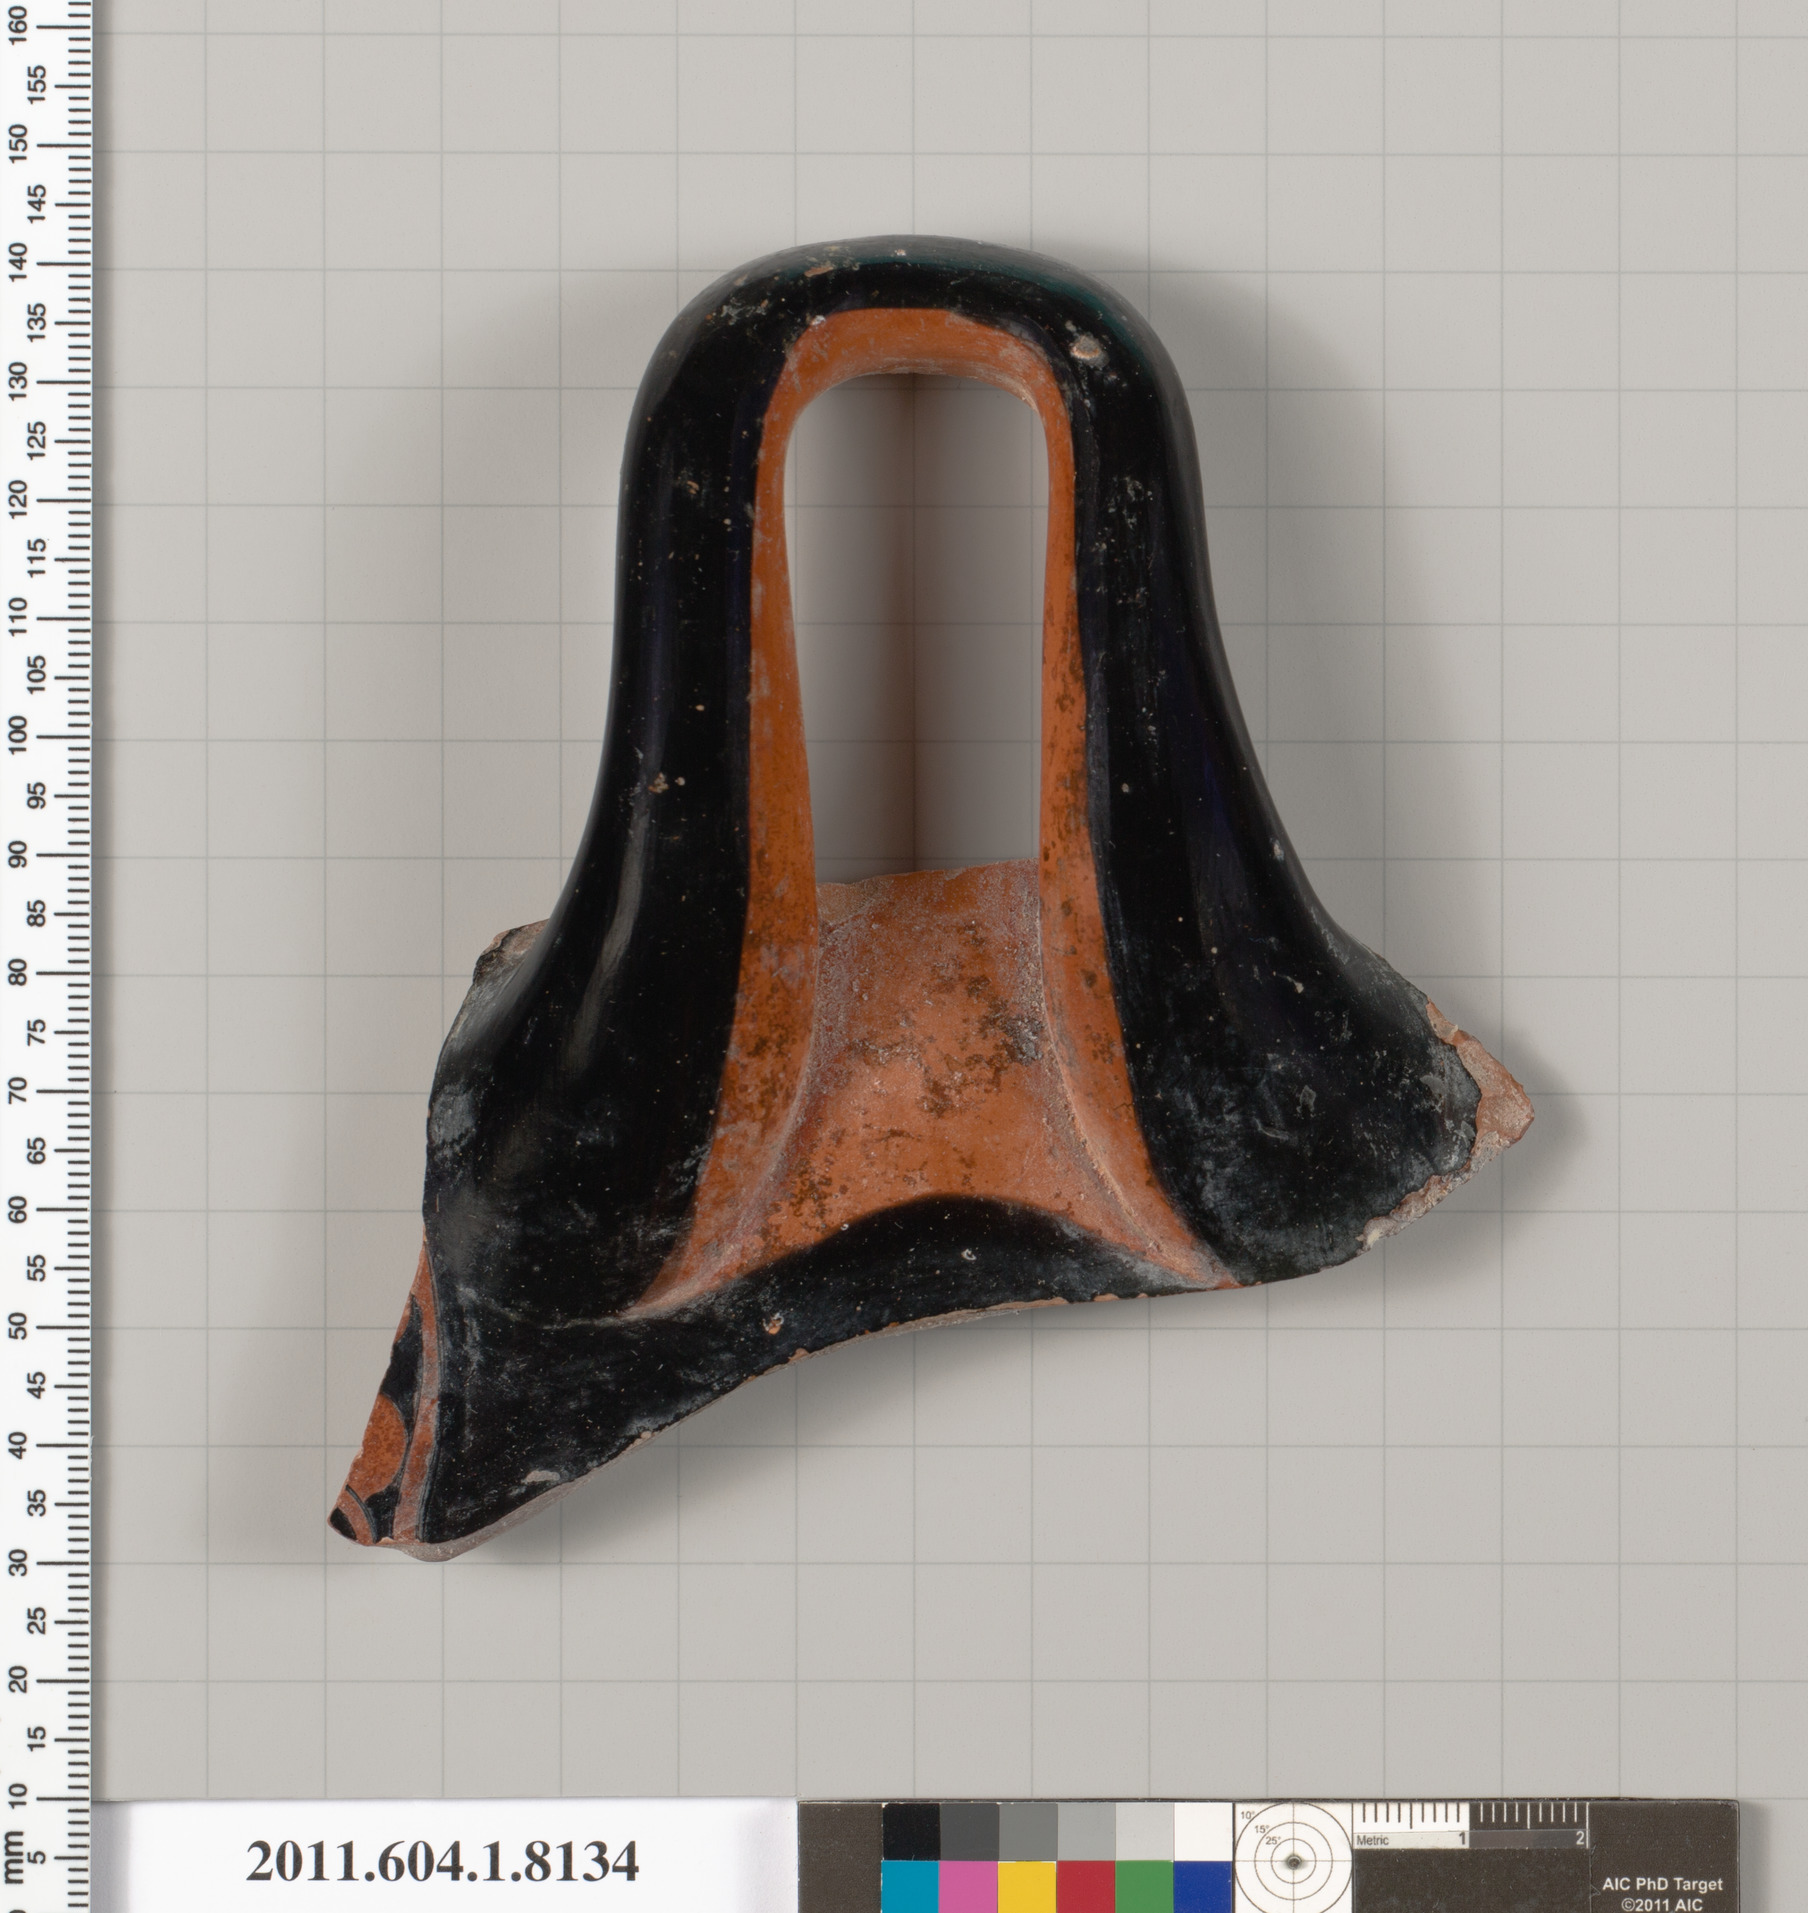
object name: kylix fragment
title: Terracotta fragment of a kylix (drinking cup)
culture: greek, attic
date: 534-468 BCE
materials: terracotta